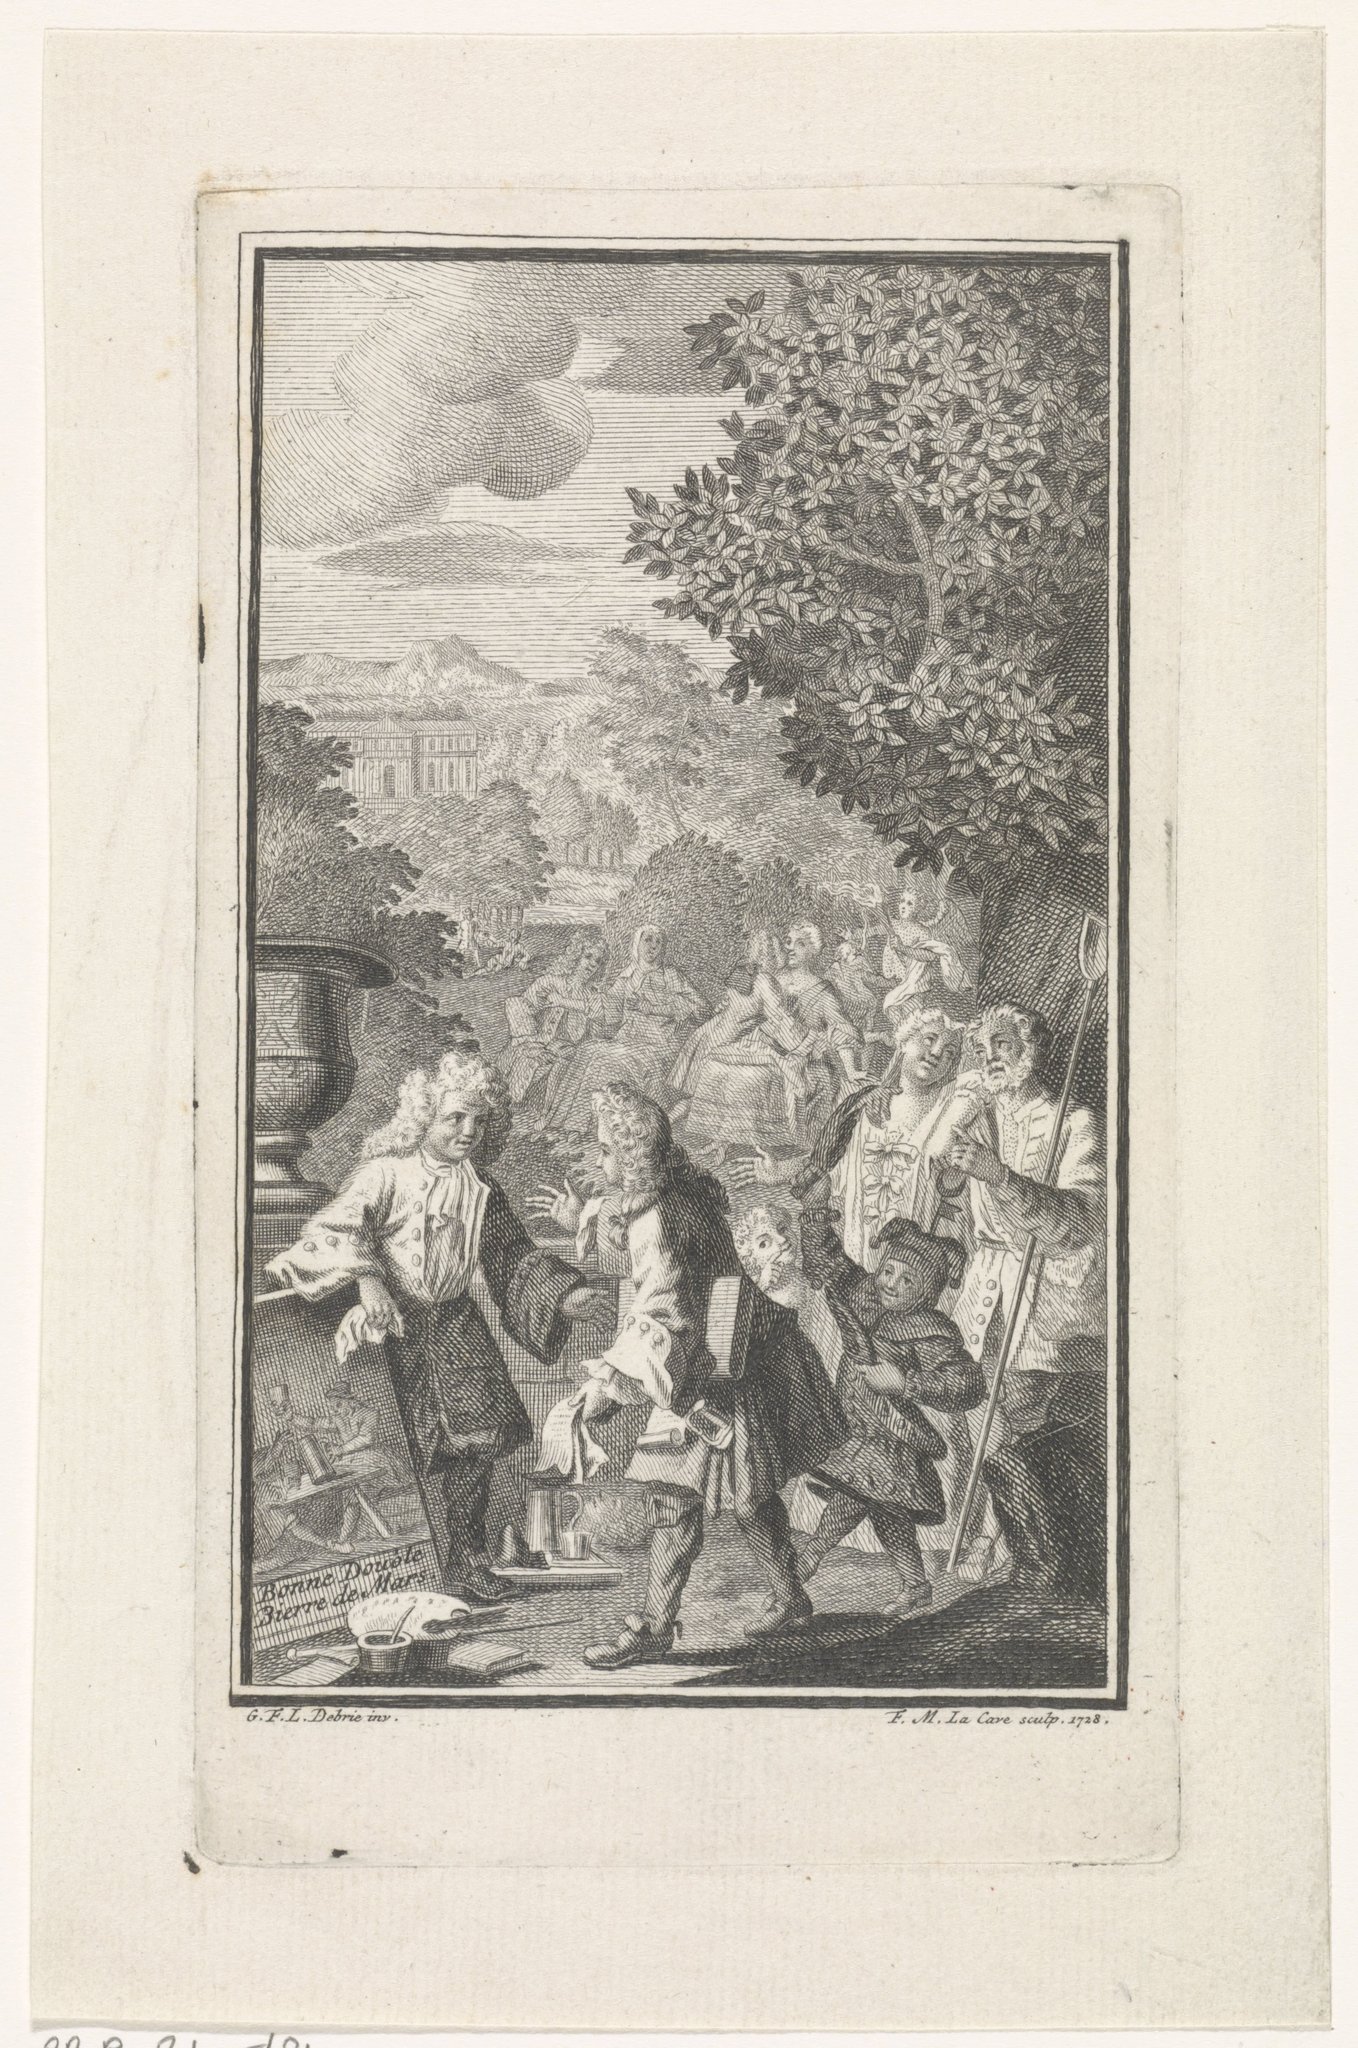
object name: print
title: Tuin met dronken en minnekozende mensen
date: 1728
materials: paper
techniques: engraving, etching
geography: amsterdam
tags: court jester, court fool, beer, ale, picture, painting, couple of lovers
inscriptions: collector's mark: Lugt 240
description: In een tuin zitten en staan verschillende minnekozende paren. Op de voorgrond staan twee mannen bij een schilderij met reclame voor bier (Bonne Double Bierre de Mars). Achter de mannen loopt een nar.